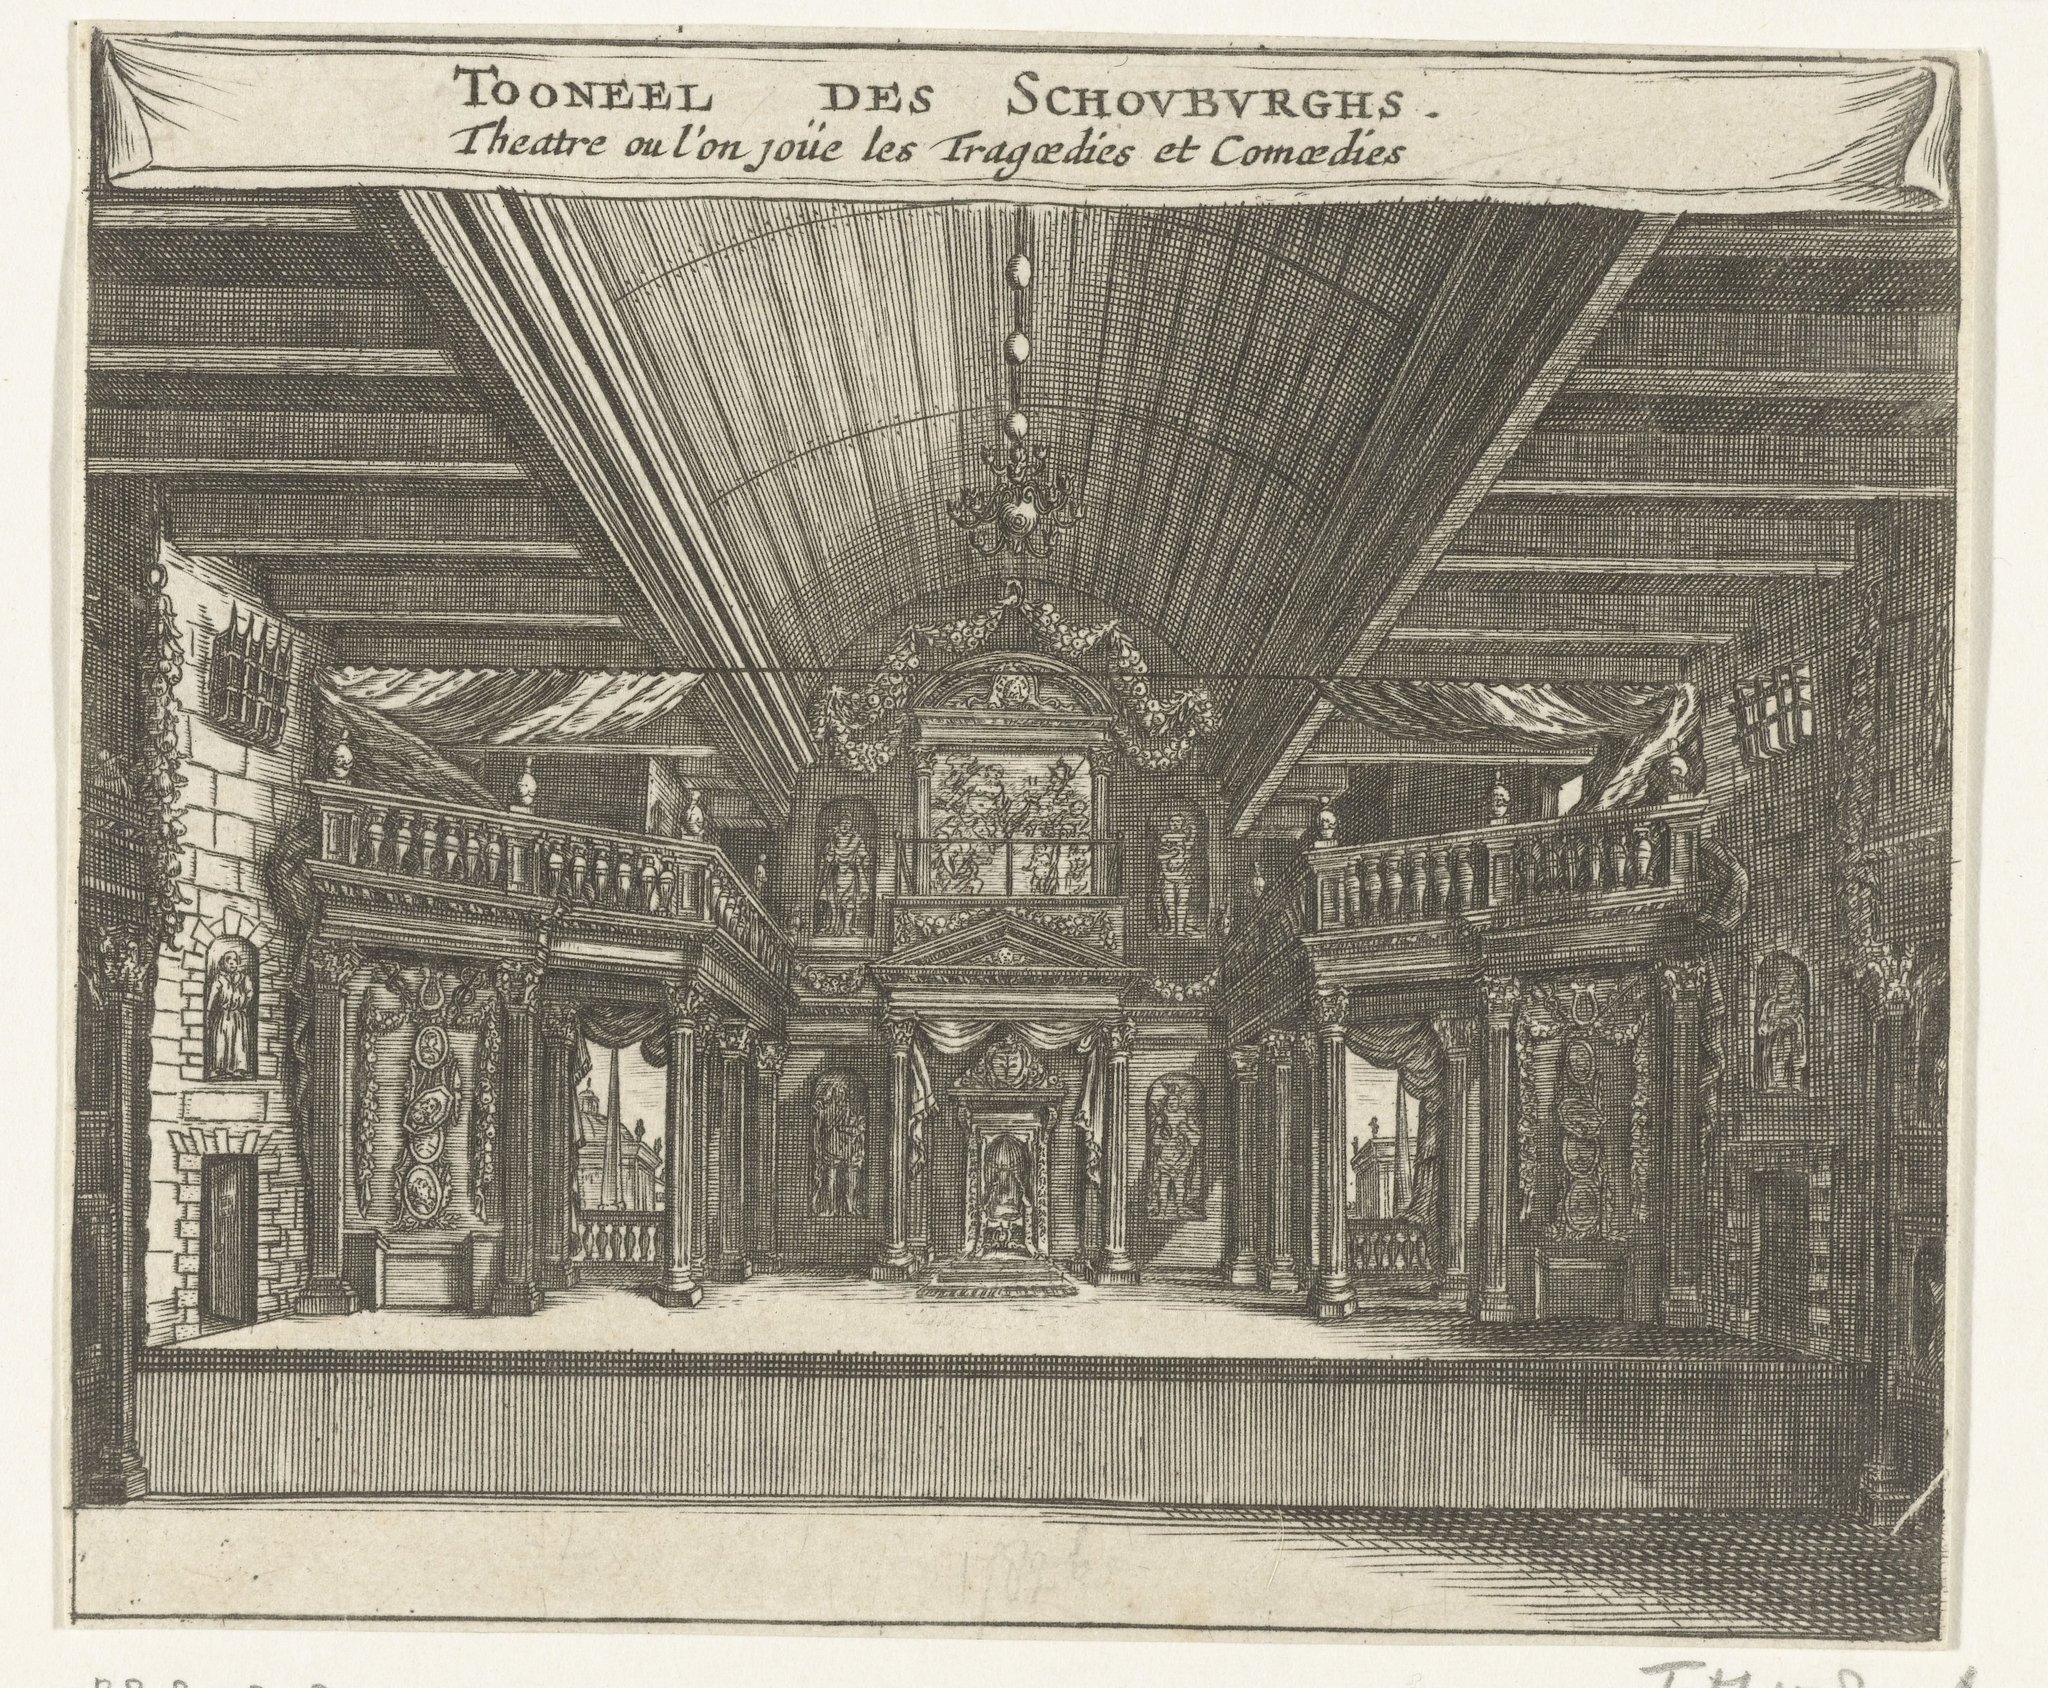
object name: print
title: Tooneel des Schouburghs / Theatre ou l'on joüe les Tragaedies et Comaedies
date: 1665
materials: paper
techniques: engraving, etching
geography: amsterdam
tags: theatre (building), the stage and its equipment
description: Huidige staat van prent ook gebruikt in: Domselaer, Tobias en Isaac Commelin. Beschryvinge van Amsterdam : haar eerste oorspronk uyt den huyze der heeren van Aemstel en Aemstellant (…). 6 delen. Amsterdam: Marcus Willemsz van Doornick, 1665. Eerste bekende staat (zonder Franse titel, zie RP-P-AO-25-33-1 en RP-P-OB-81.424) ook gebruikt in: Fockens, Melchior. Beschrijving Der wijdt-vermaarde Koop-stadt Amstelredam, Van haar eerste beginselen, zedert den Jare 1203. oude Voorrechten, verscheyde Vergrootingenoude Voor-rechten, en verscheyde Vergrootingen (…). 3e druk. Amsterdam: Marcus Willemsz. Doornick, 1664. En in: Zesen, Philipp von. Beschrybung der Weidtberuhmde Kauf-Stadt Amstelredam / Beschreibung der Stadt Amsterdam darinnen von derselben ersten ursprunge bis auf gegenwartigen zustand (…). Amsterdam: Marcus Willemsz. Doornick, 1664. Derde bekende staat (rechtsboven genummerd: 39) ook gebruikt in verschillende latere zeventiende- en achttiende-eeuwse publicaties.